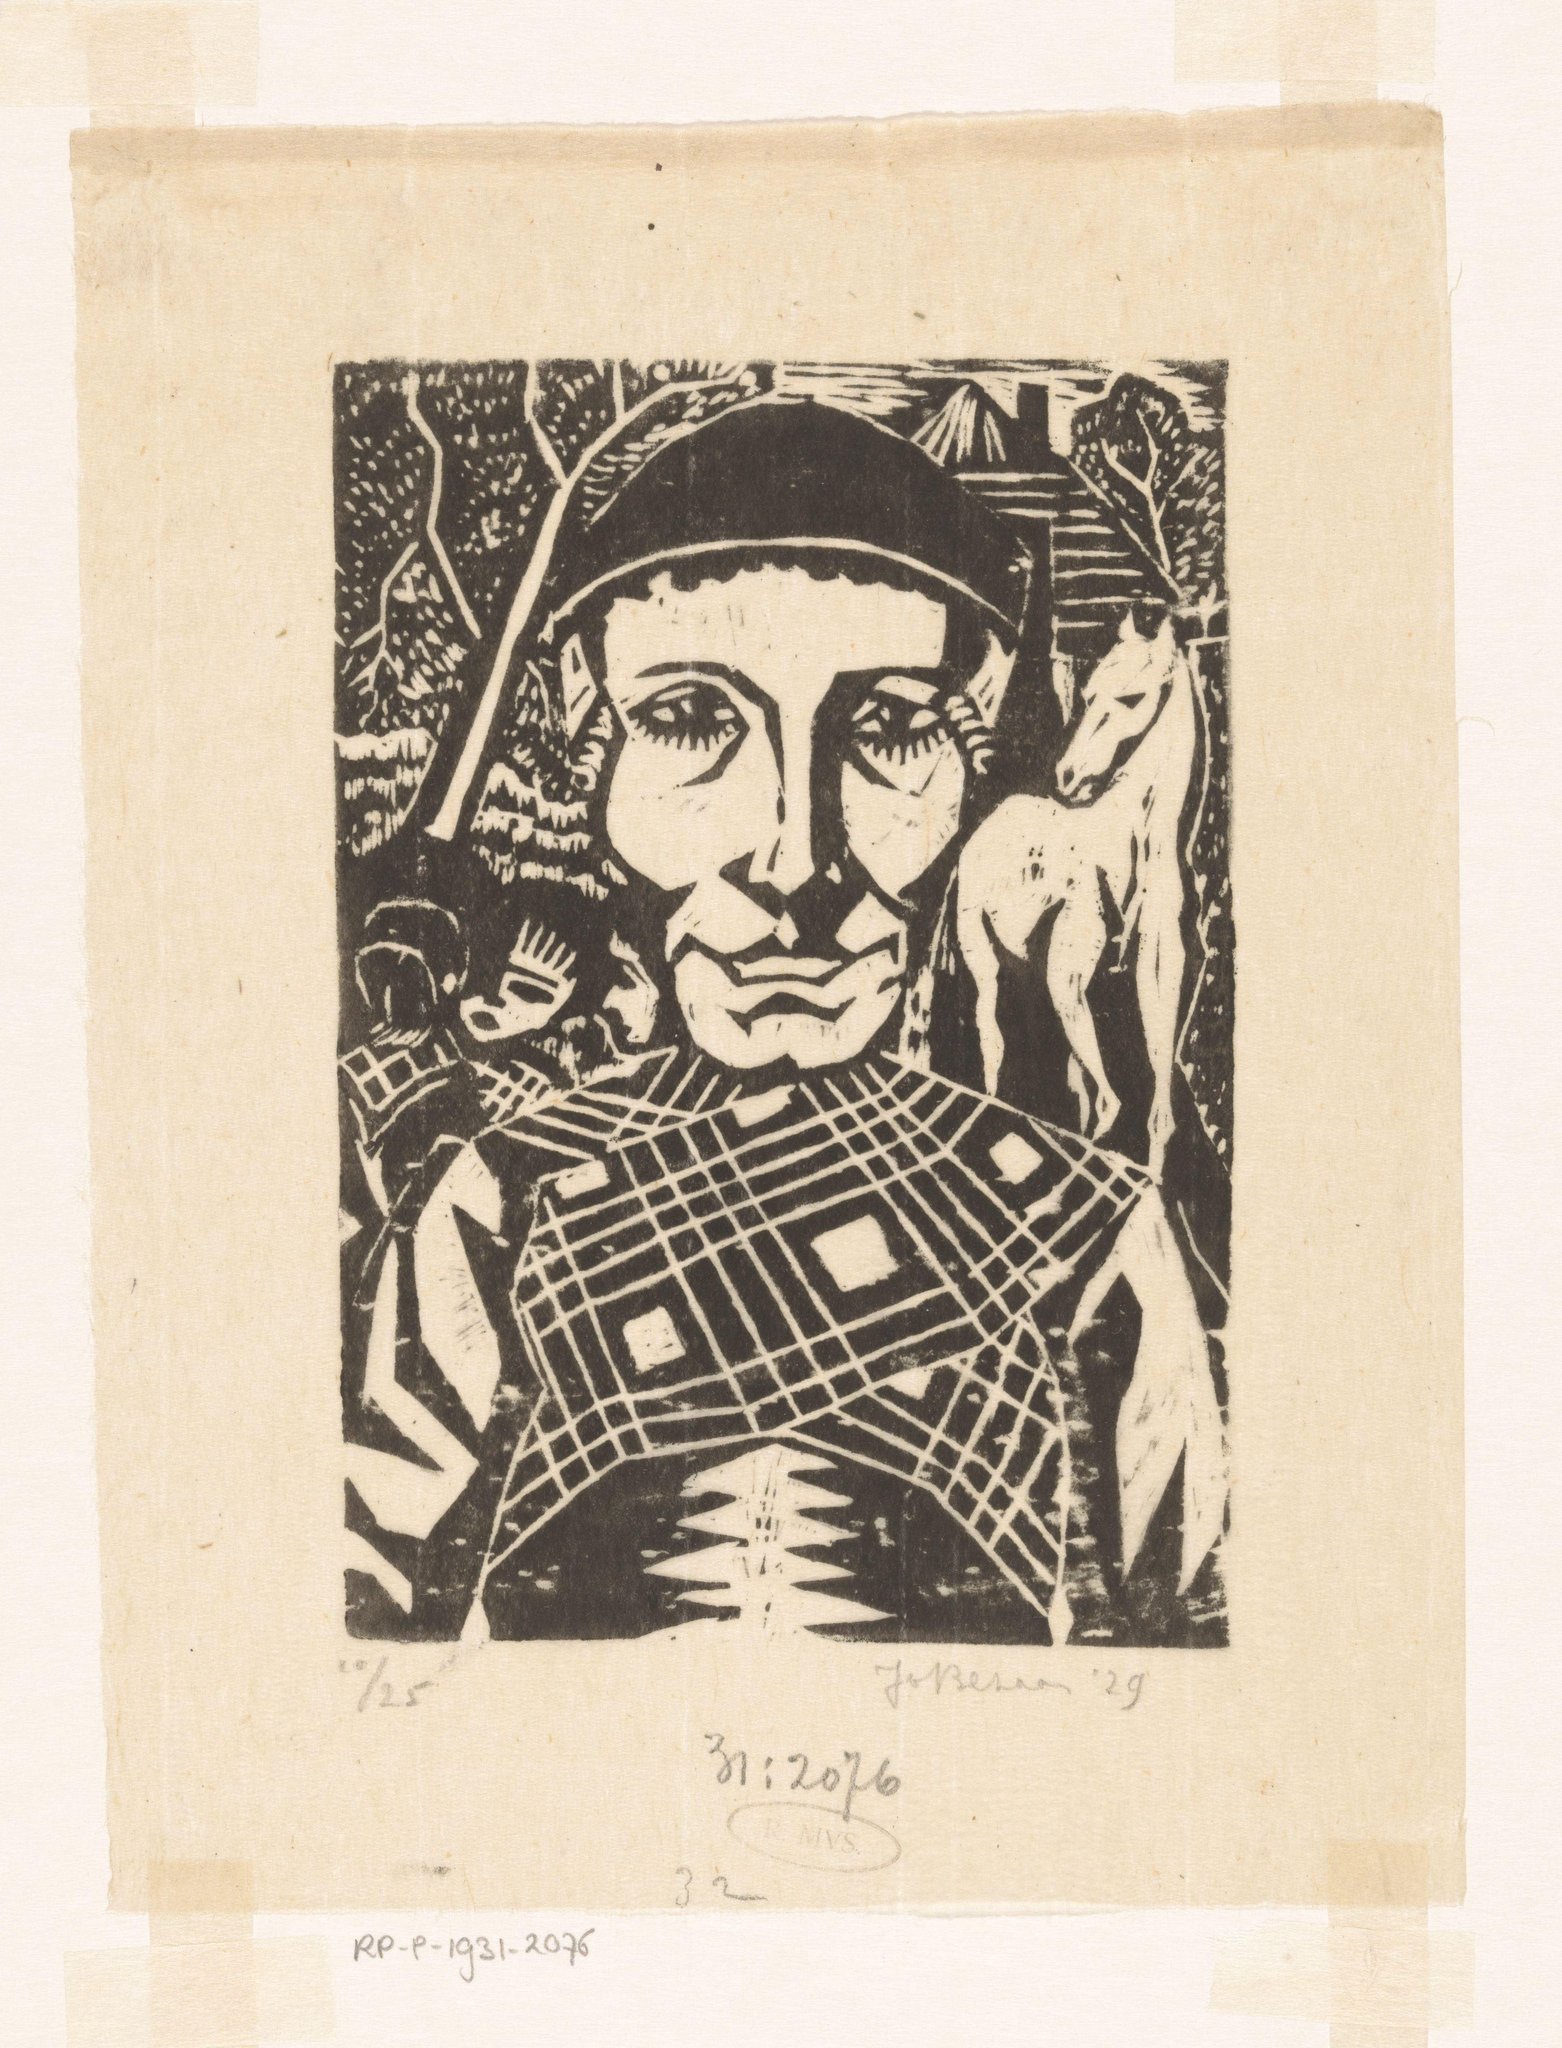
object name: print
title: Boerin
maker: jo bezaan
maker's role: draughtsman, print maker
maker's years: 1894-1952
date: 1929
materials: paper, ink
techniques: woodcut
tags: farmers - aa - female farmer, farmer's wife, folk costume, regional costume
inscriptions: collector's mark: Lugt 2228, signature and date: ‘JoBezaan '29’, edition: ‘10/25’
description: Boerin ten halven lijve, aanziend, in klederdracht met achter haar een wit paard en jonge meisjes.